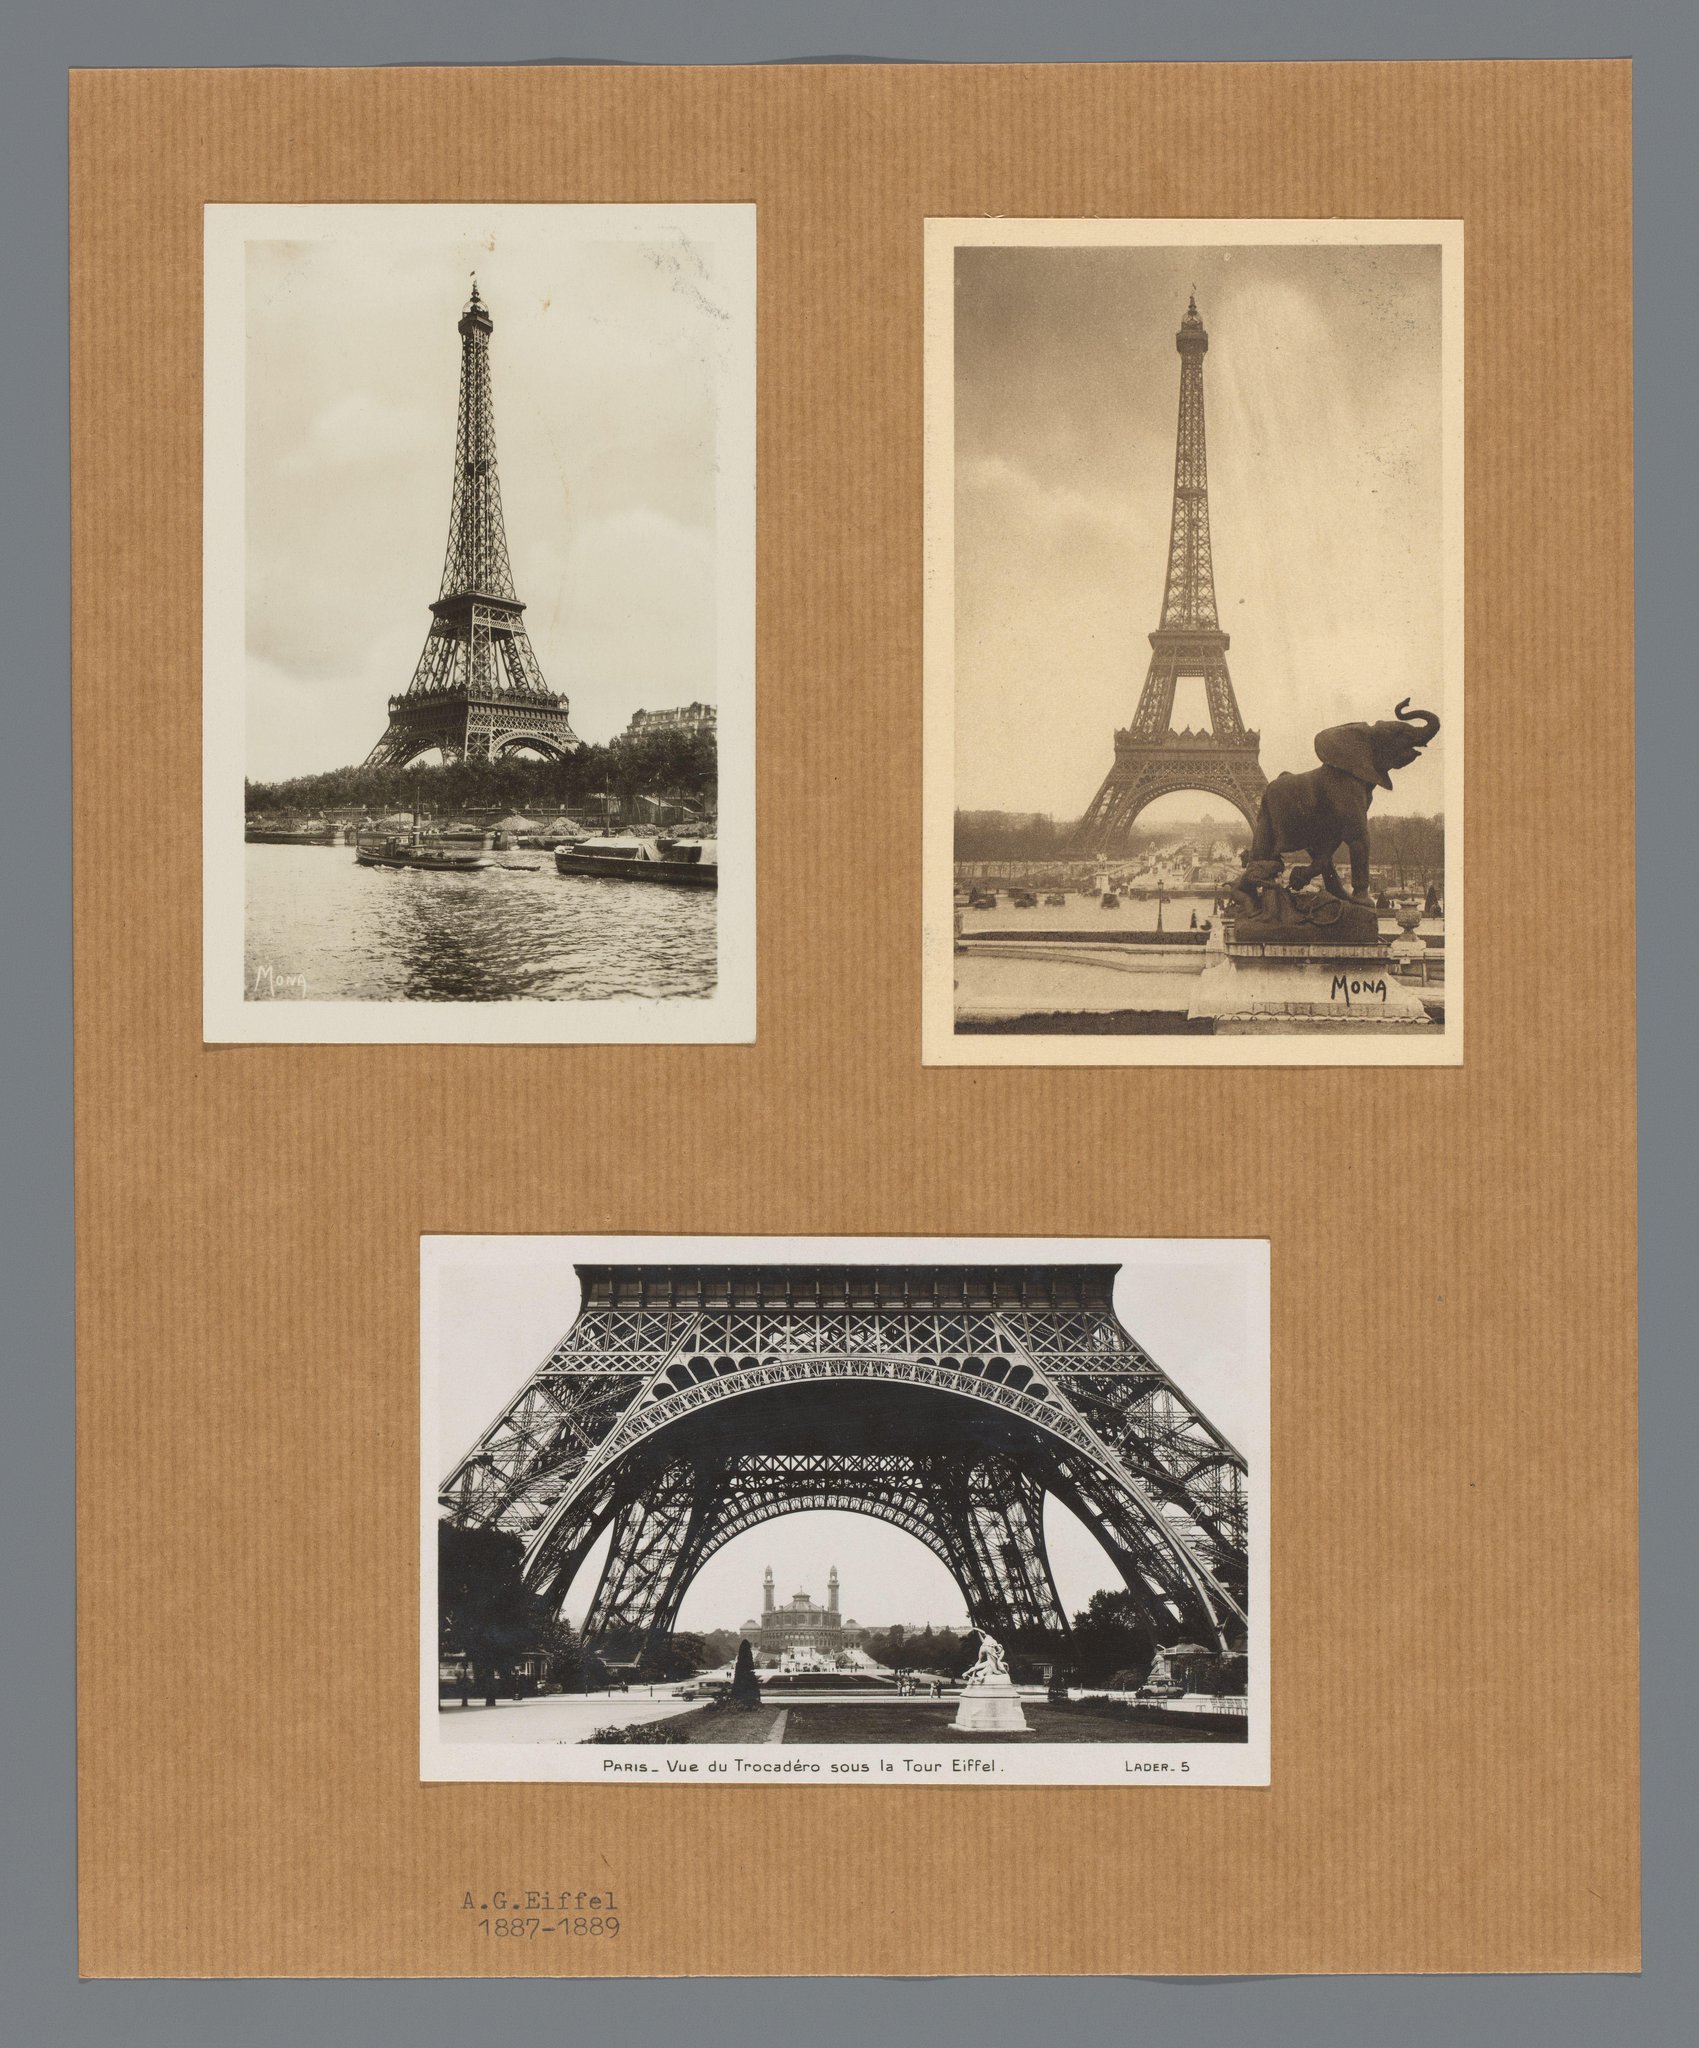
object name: photograph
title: Paris. Eiffeltoren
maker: Anonymous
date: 1887-1889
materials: photographic support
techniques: gelatin silver print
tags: eiffel tower